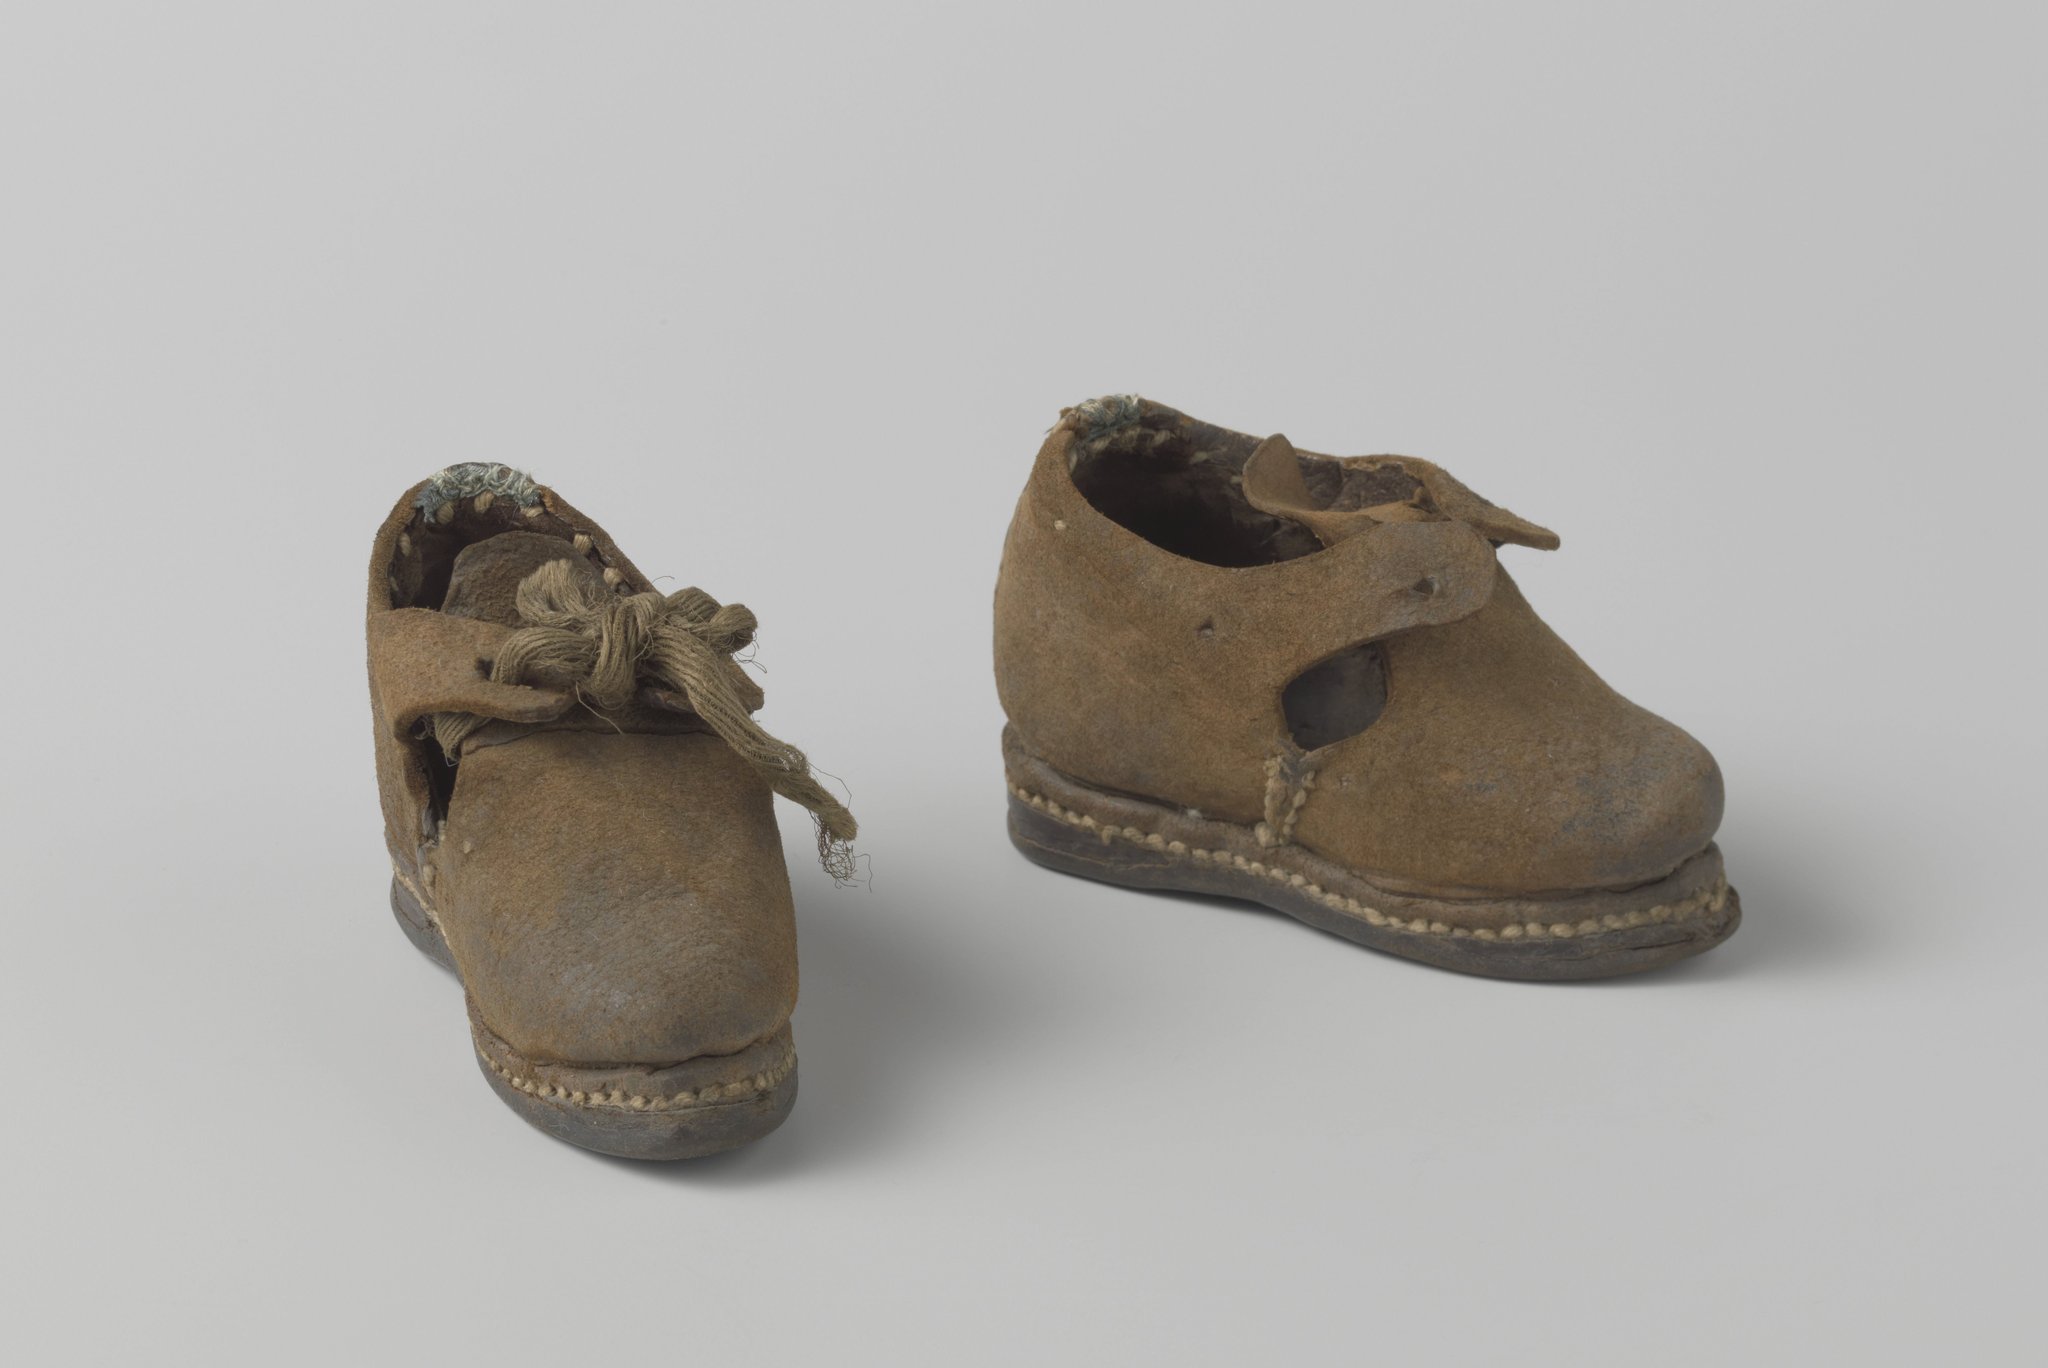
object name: poppenschoen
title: Schoen van beige leer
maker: Anonymous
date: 1600-1699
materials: leather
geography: netherlands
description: Schoen , mogelijk een poppenschoen, van beige leer. Doorlopende zool met ingebouwde hak van laagje leer. Sluiting hoog op de wreef met tong en twee lippen. Bijeen gehouden door zijden lint